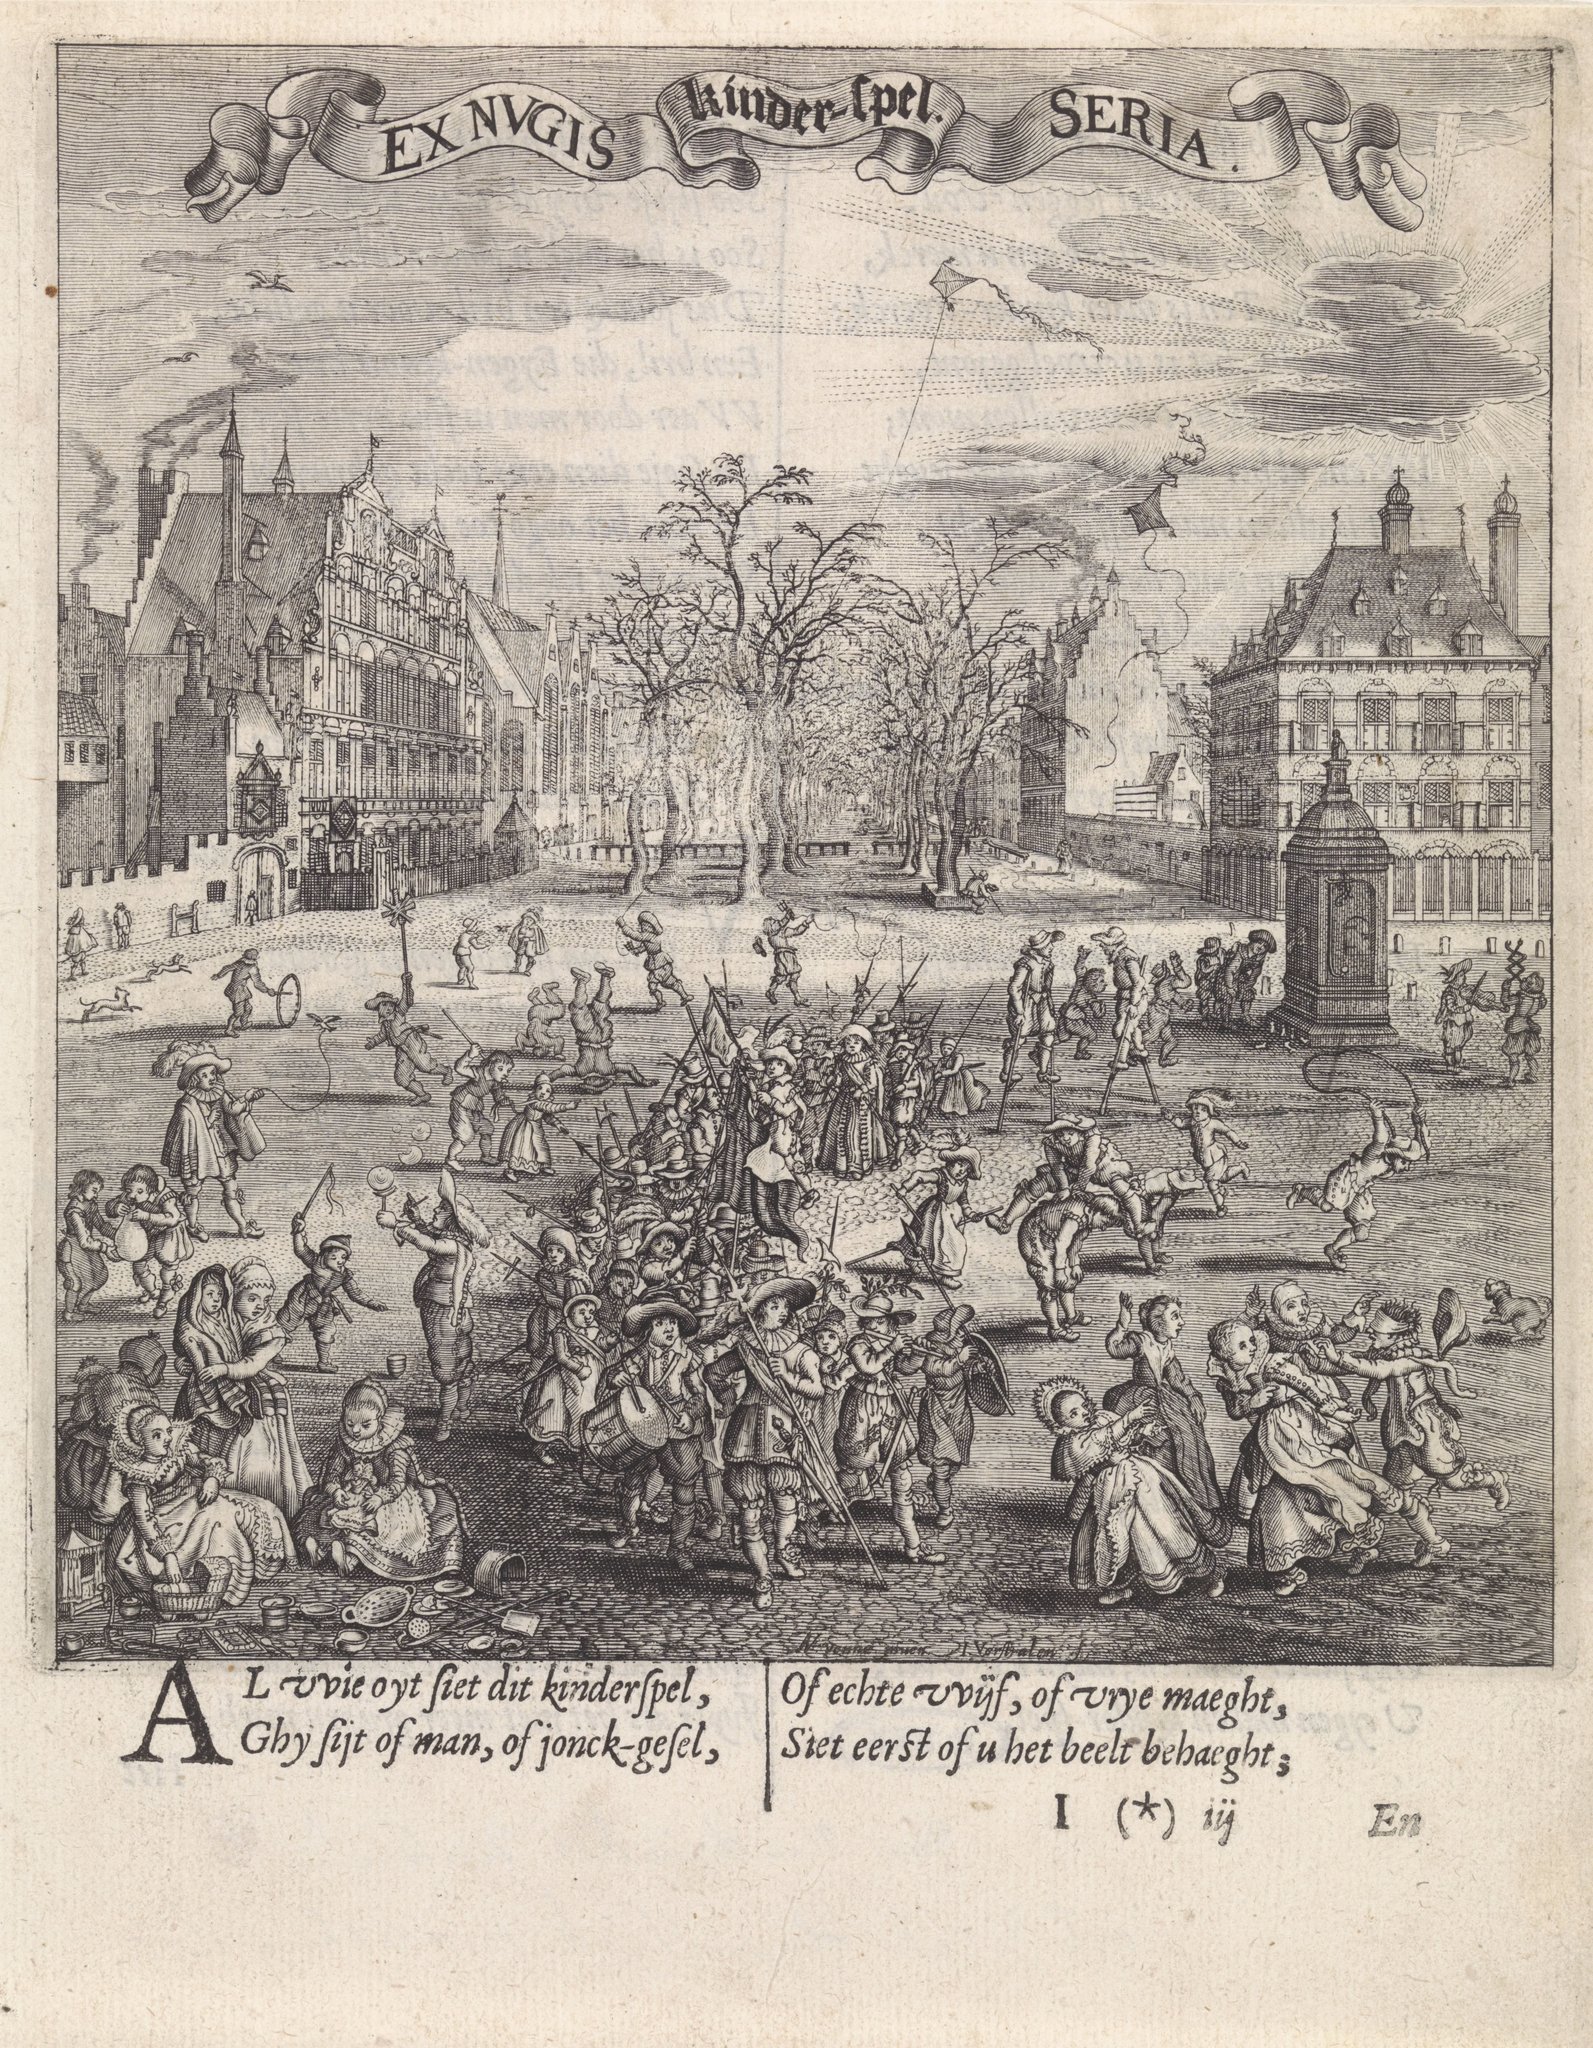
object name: book illustration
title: Kinder-spel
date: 1625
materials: paper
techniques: engraving, etching, letterpress printing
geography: middelburg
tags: children's games and plays, (playing with) toys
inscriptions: collector's mark: Lugt 2228, collector's mark: Lugt 2760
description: Prent gebruikt in: Cats, Jacob. Houwelyck. Dat is de gansche gelegentheyt des echten staets. Middelburg: weduwe Jan Pietersz. van de Venne, 1625.